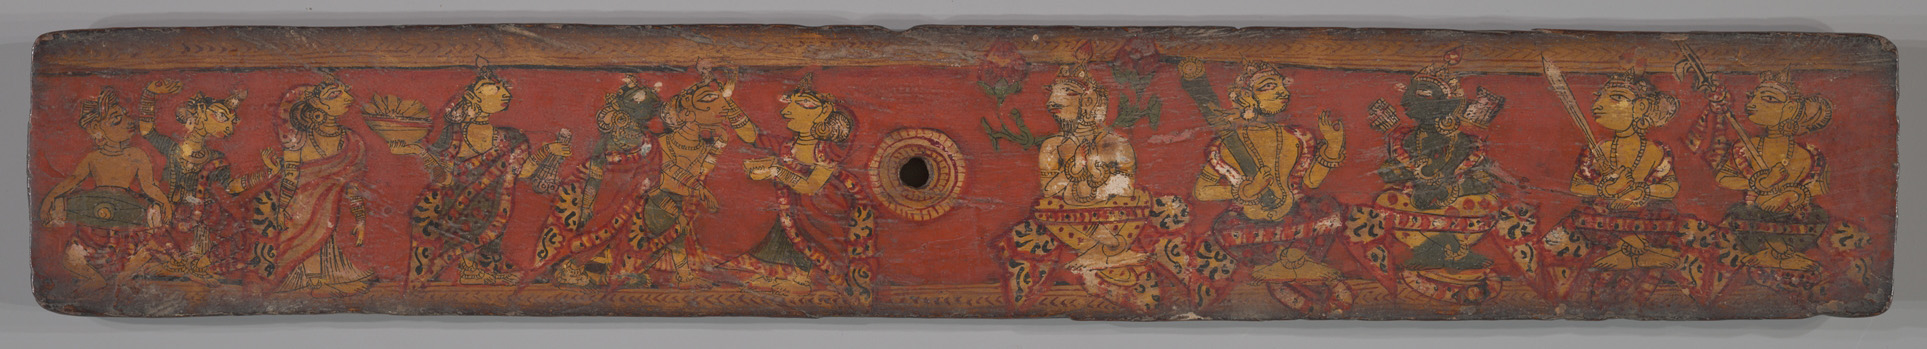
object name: painting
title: One of a Pair of Jain Manuscript Covers (Patli)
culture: indian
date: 1101-1133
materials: watercolor, wood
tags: men,women